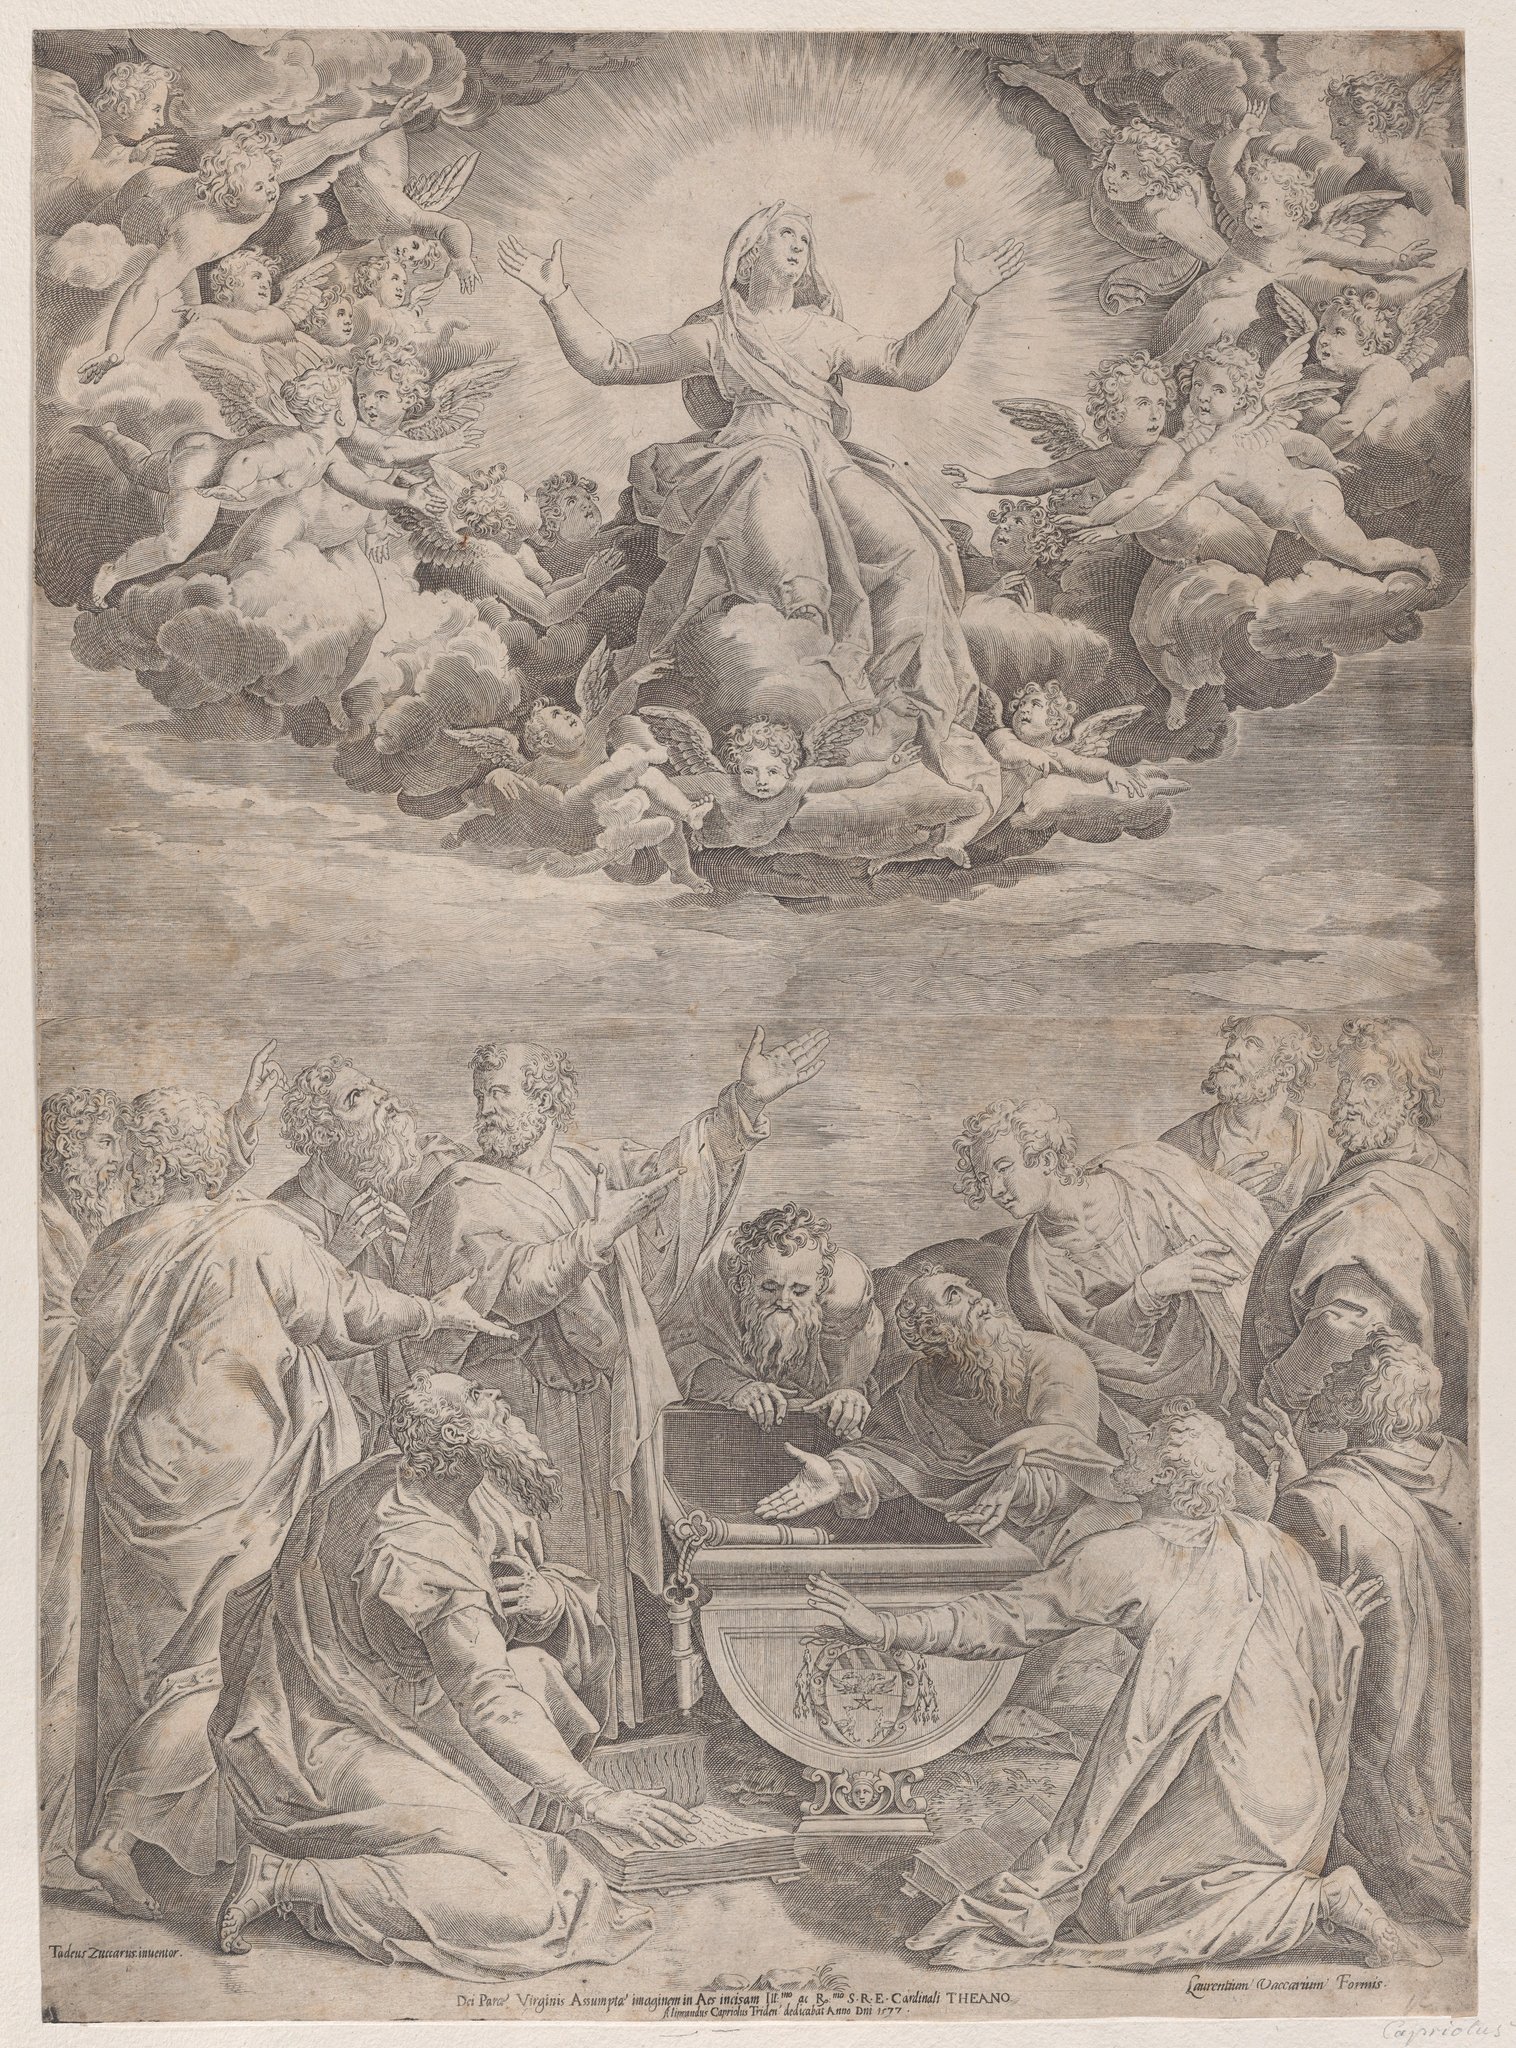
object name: print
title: Assumption of the Virgin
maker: aliprando caprioli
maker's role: artist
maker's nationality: italian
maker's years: 1574-1599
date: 1574-1599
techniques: engraving